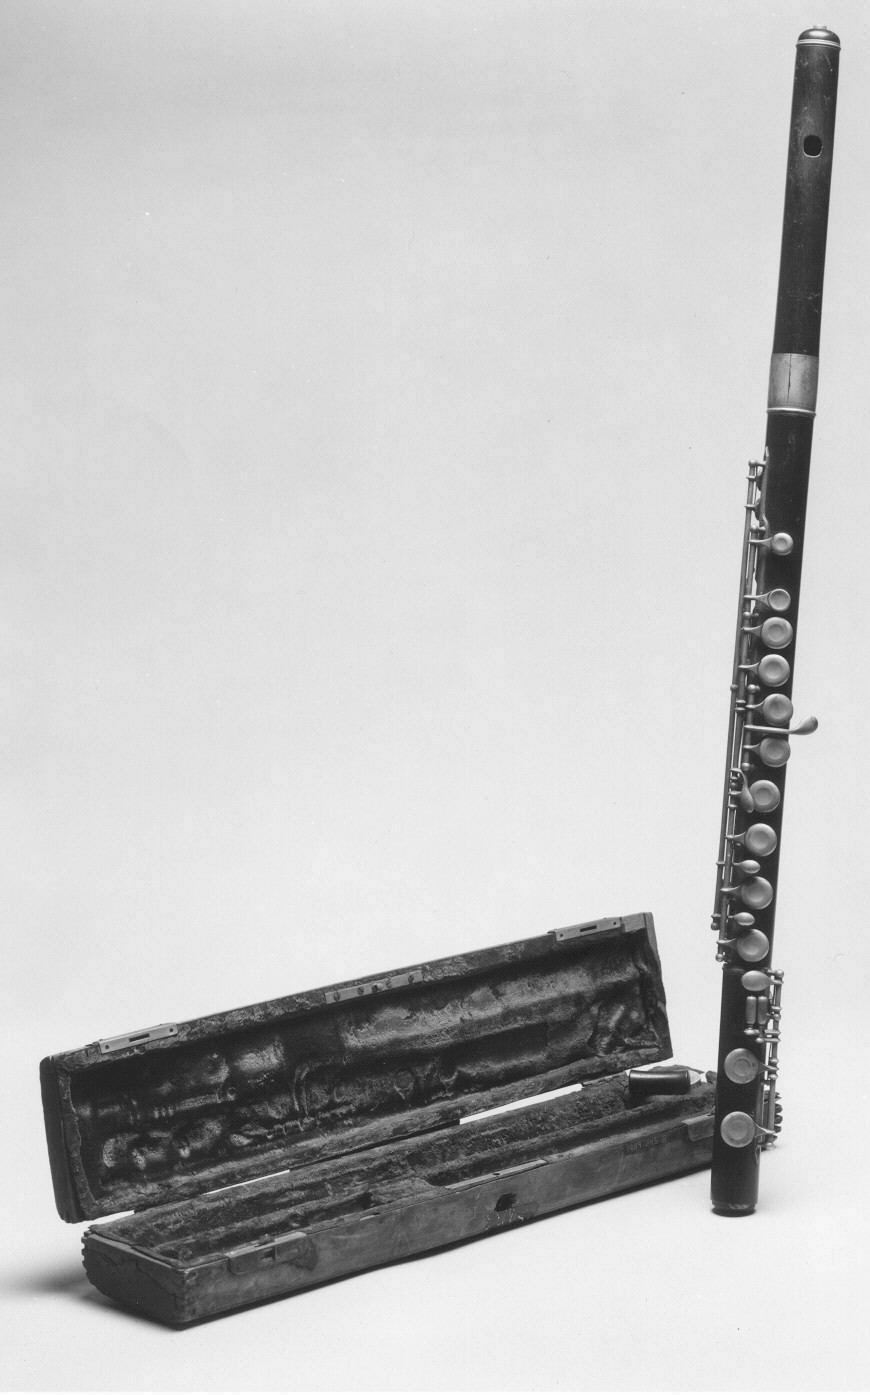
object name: transverse flute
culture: american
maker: william r. meinell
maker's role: maker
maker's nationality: german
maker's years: 1846-1927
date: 1880-1900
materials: nickel, silver, wood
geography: united states